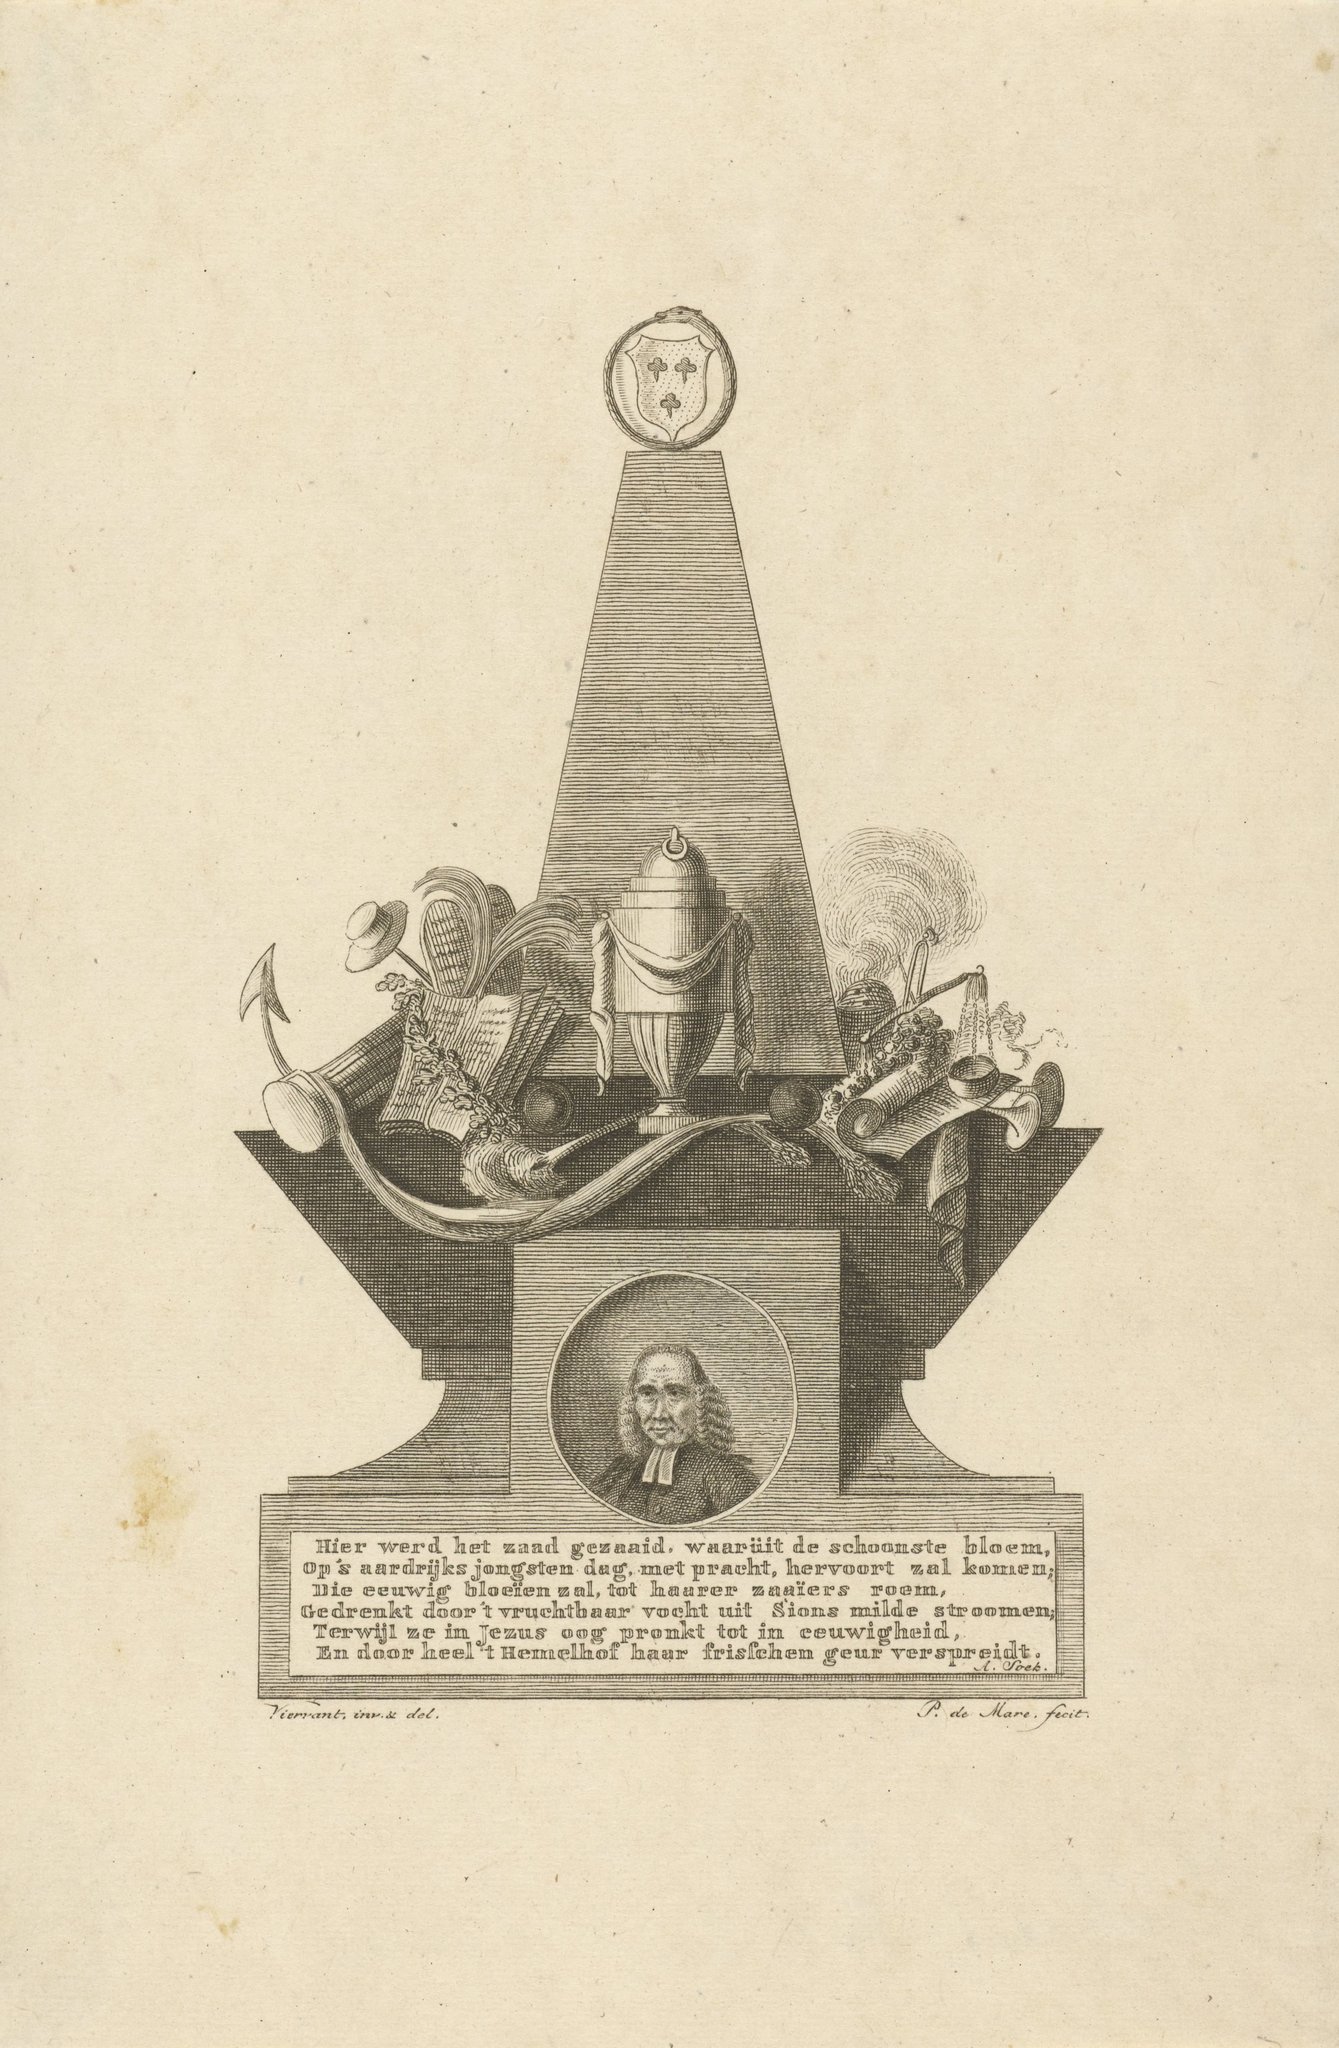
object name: print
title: Gedenkteken voor Gualtherus Zoutmaat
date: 1793-1796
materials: paper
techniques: engraving, etching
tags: grave, tomb and other grave-forms and grave-markers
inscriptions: collector's mark: Lugt 2228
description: Gedenkteken voor de predikant Gualtherus Zoutmaat.